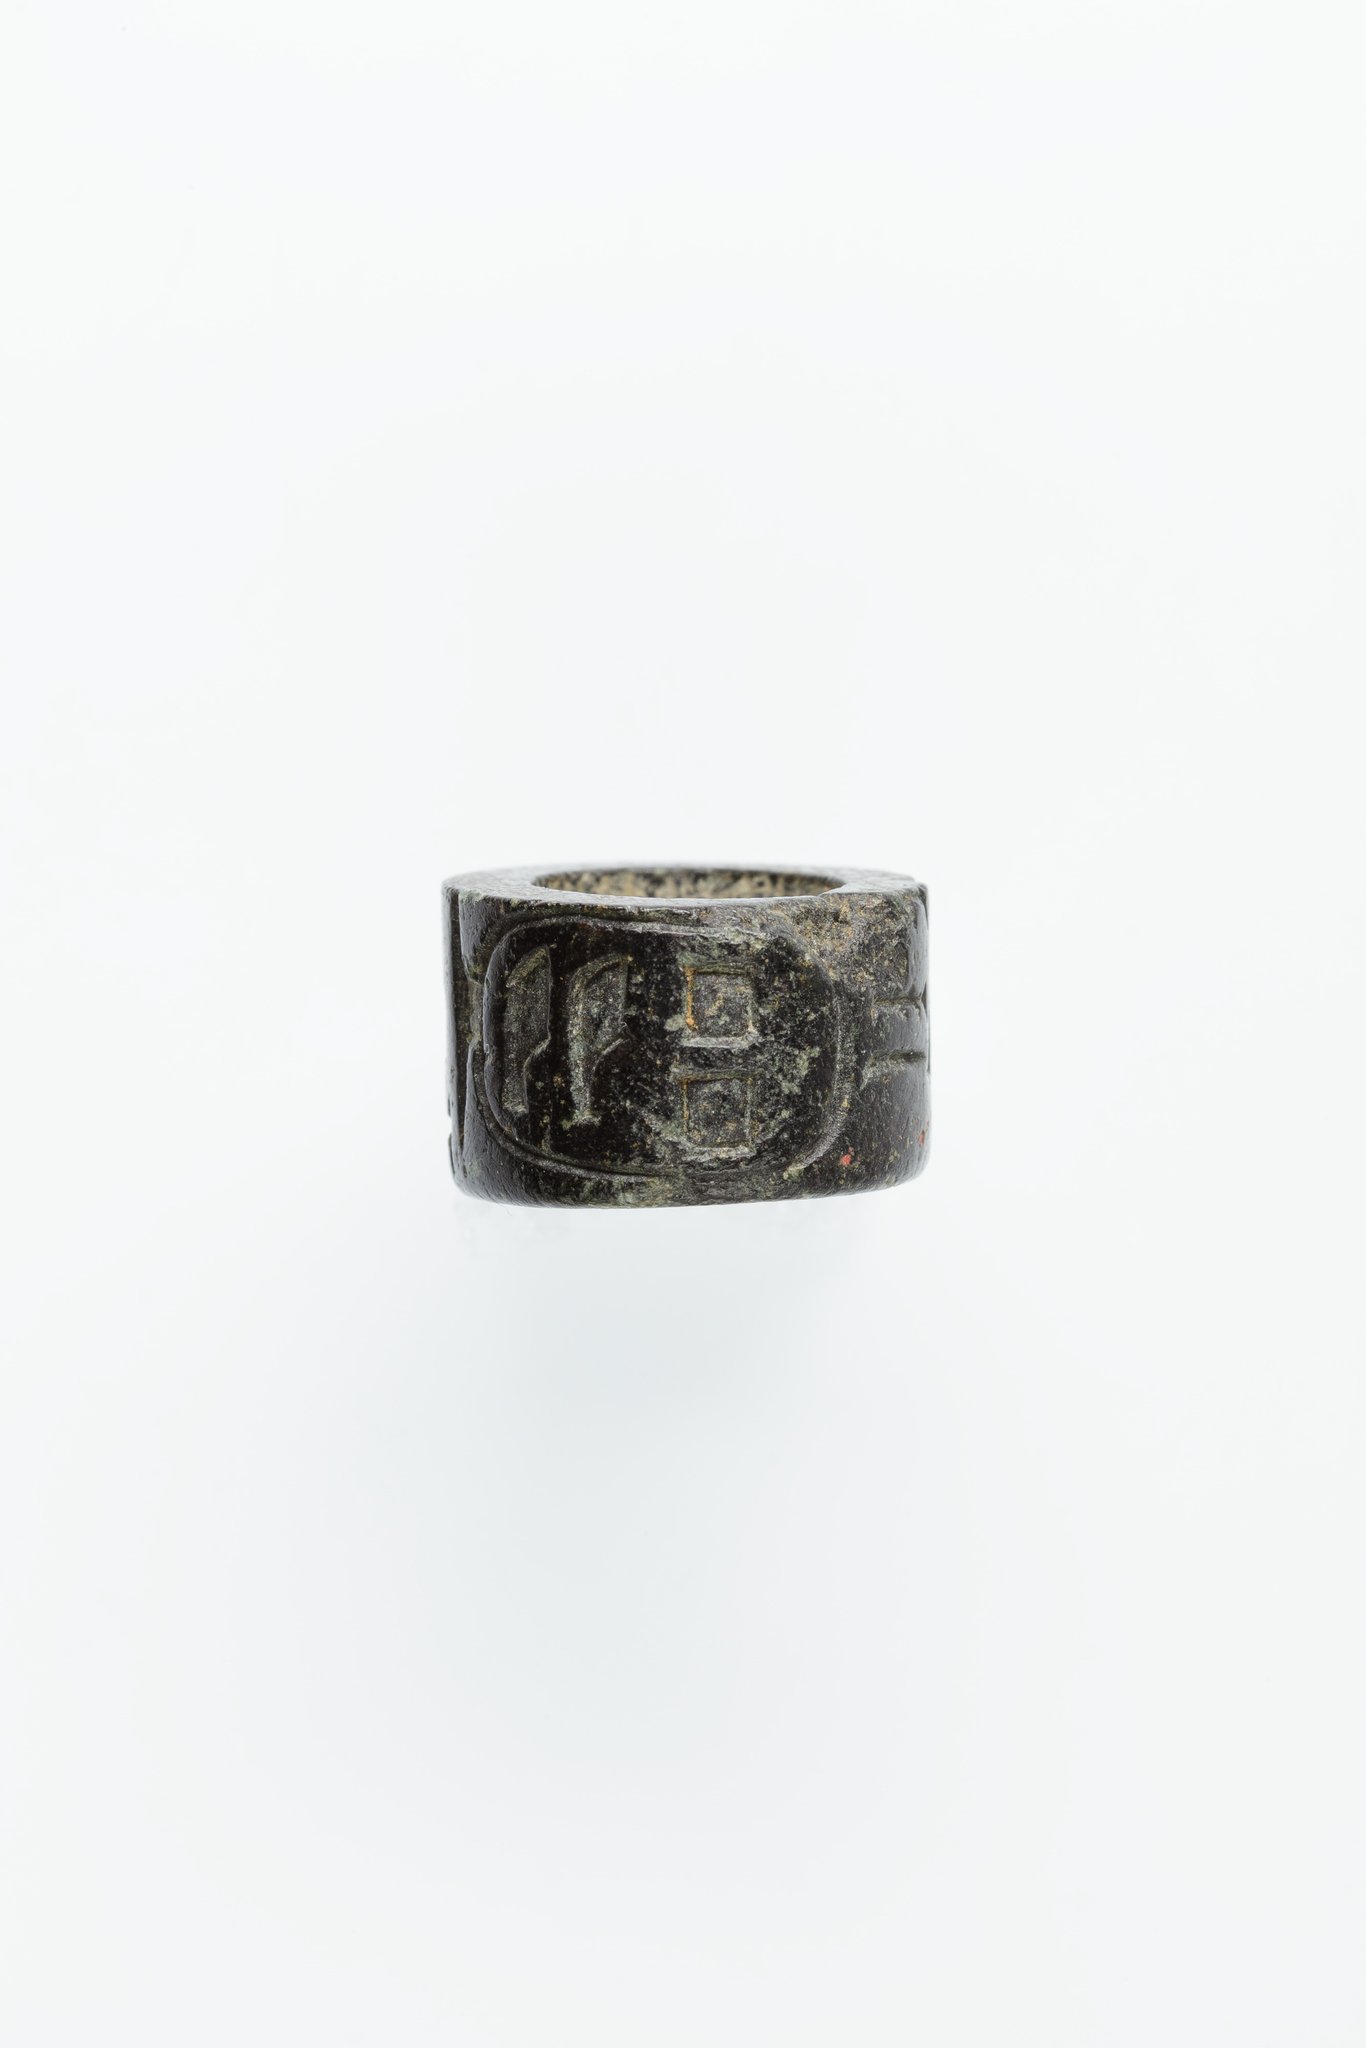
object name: cylinder seal, pepi i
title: Cylinder Seal with the Name of Pepi I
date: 2289-2255 BCE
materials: stone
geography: egypt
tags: hieroglyphs